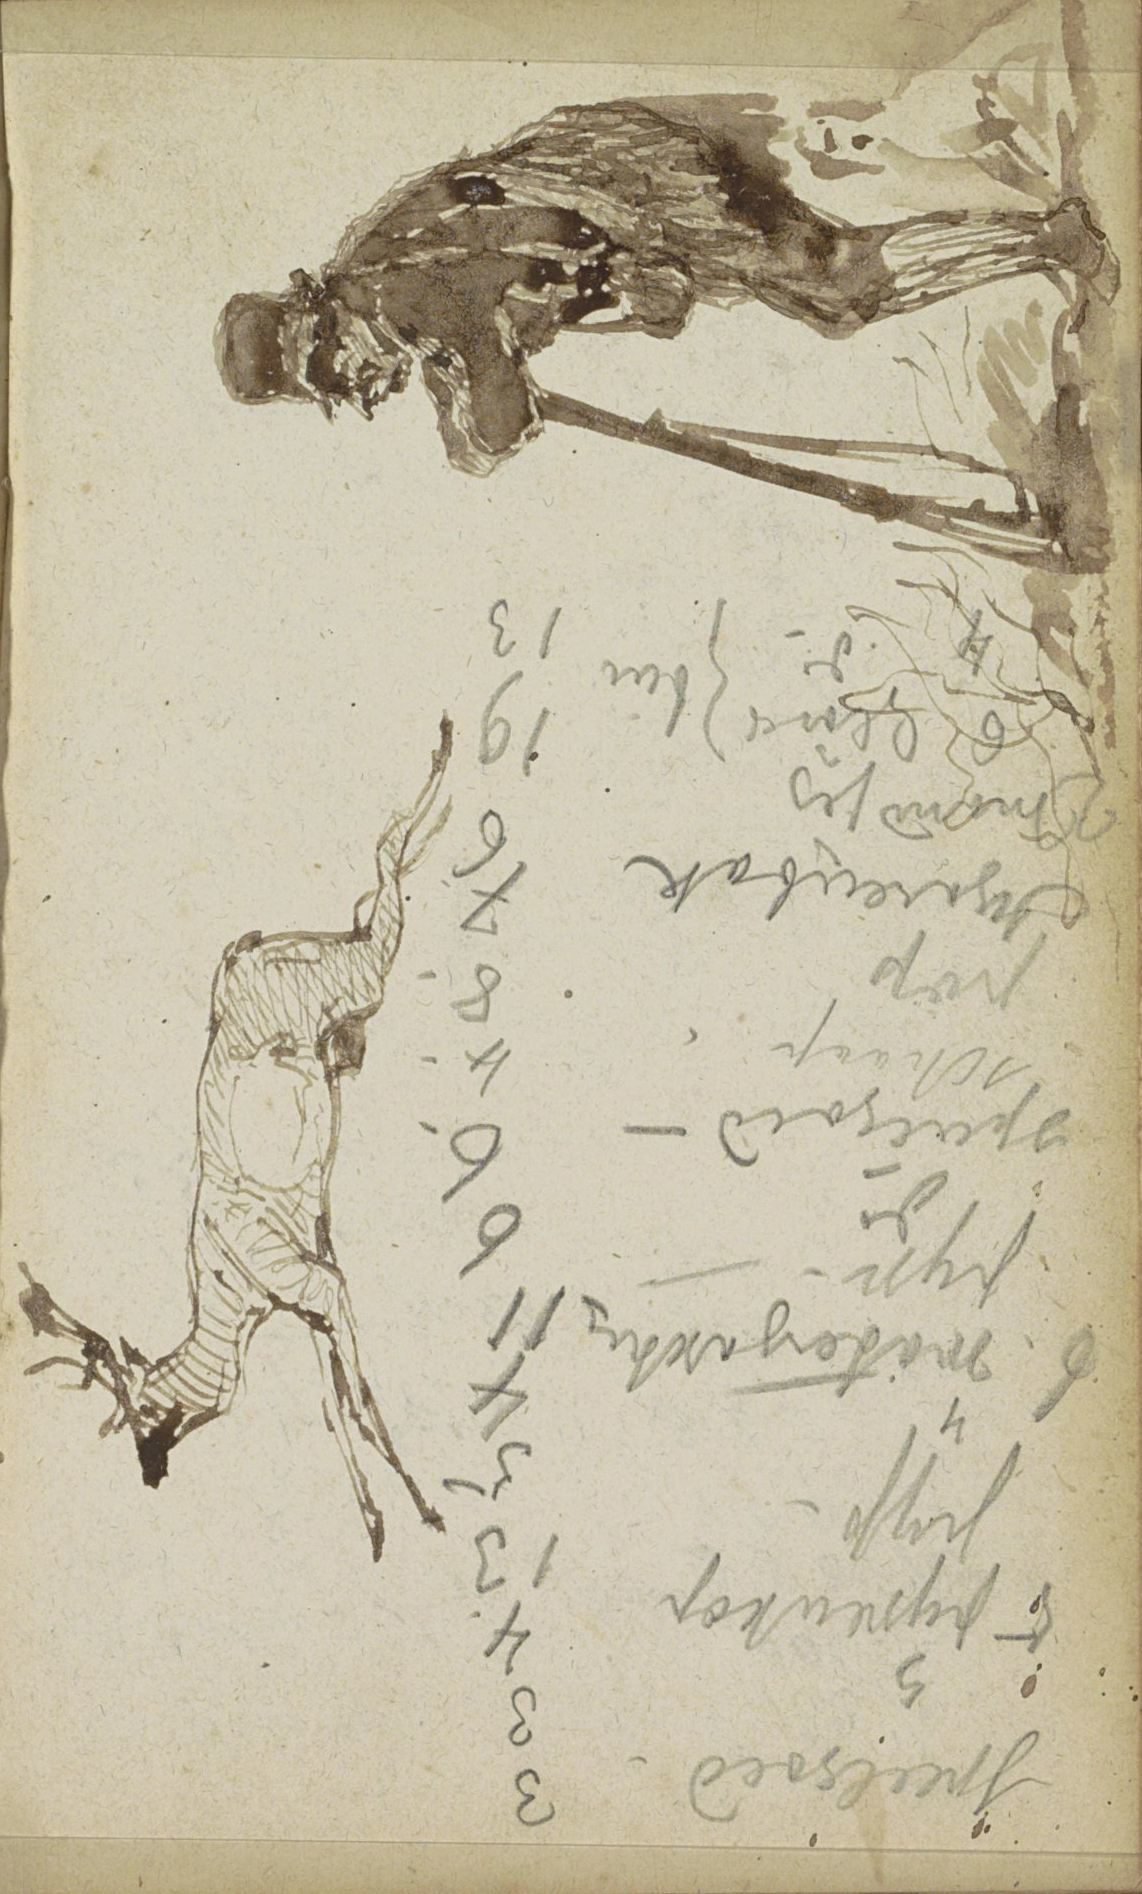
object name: sketchbook leaf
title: Hert en een jager leunend op zijn geweer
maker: johannes tavenraat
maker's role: draughtsman, painter, print maker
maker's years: 1809-1881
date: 1854-1868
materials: ink, paper, pencil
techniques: brush, pen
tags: hoofed animals: deer, hunter, firearms, leaning figure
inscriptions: annotation: ‘[...]’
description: Blad 85 recto uit een schetsboek met 88 bladen.